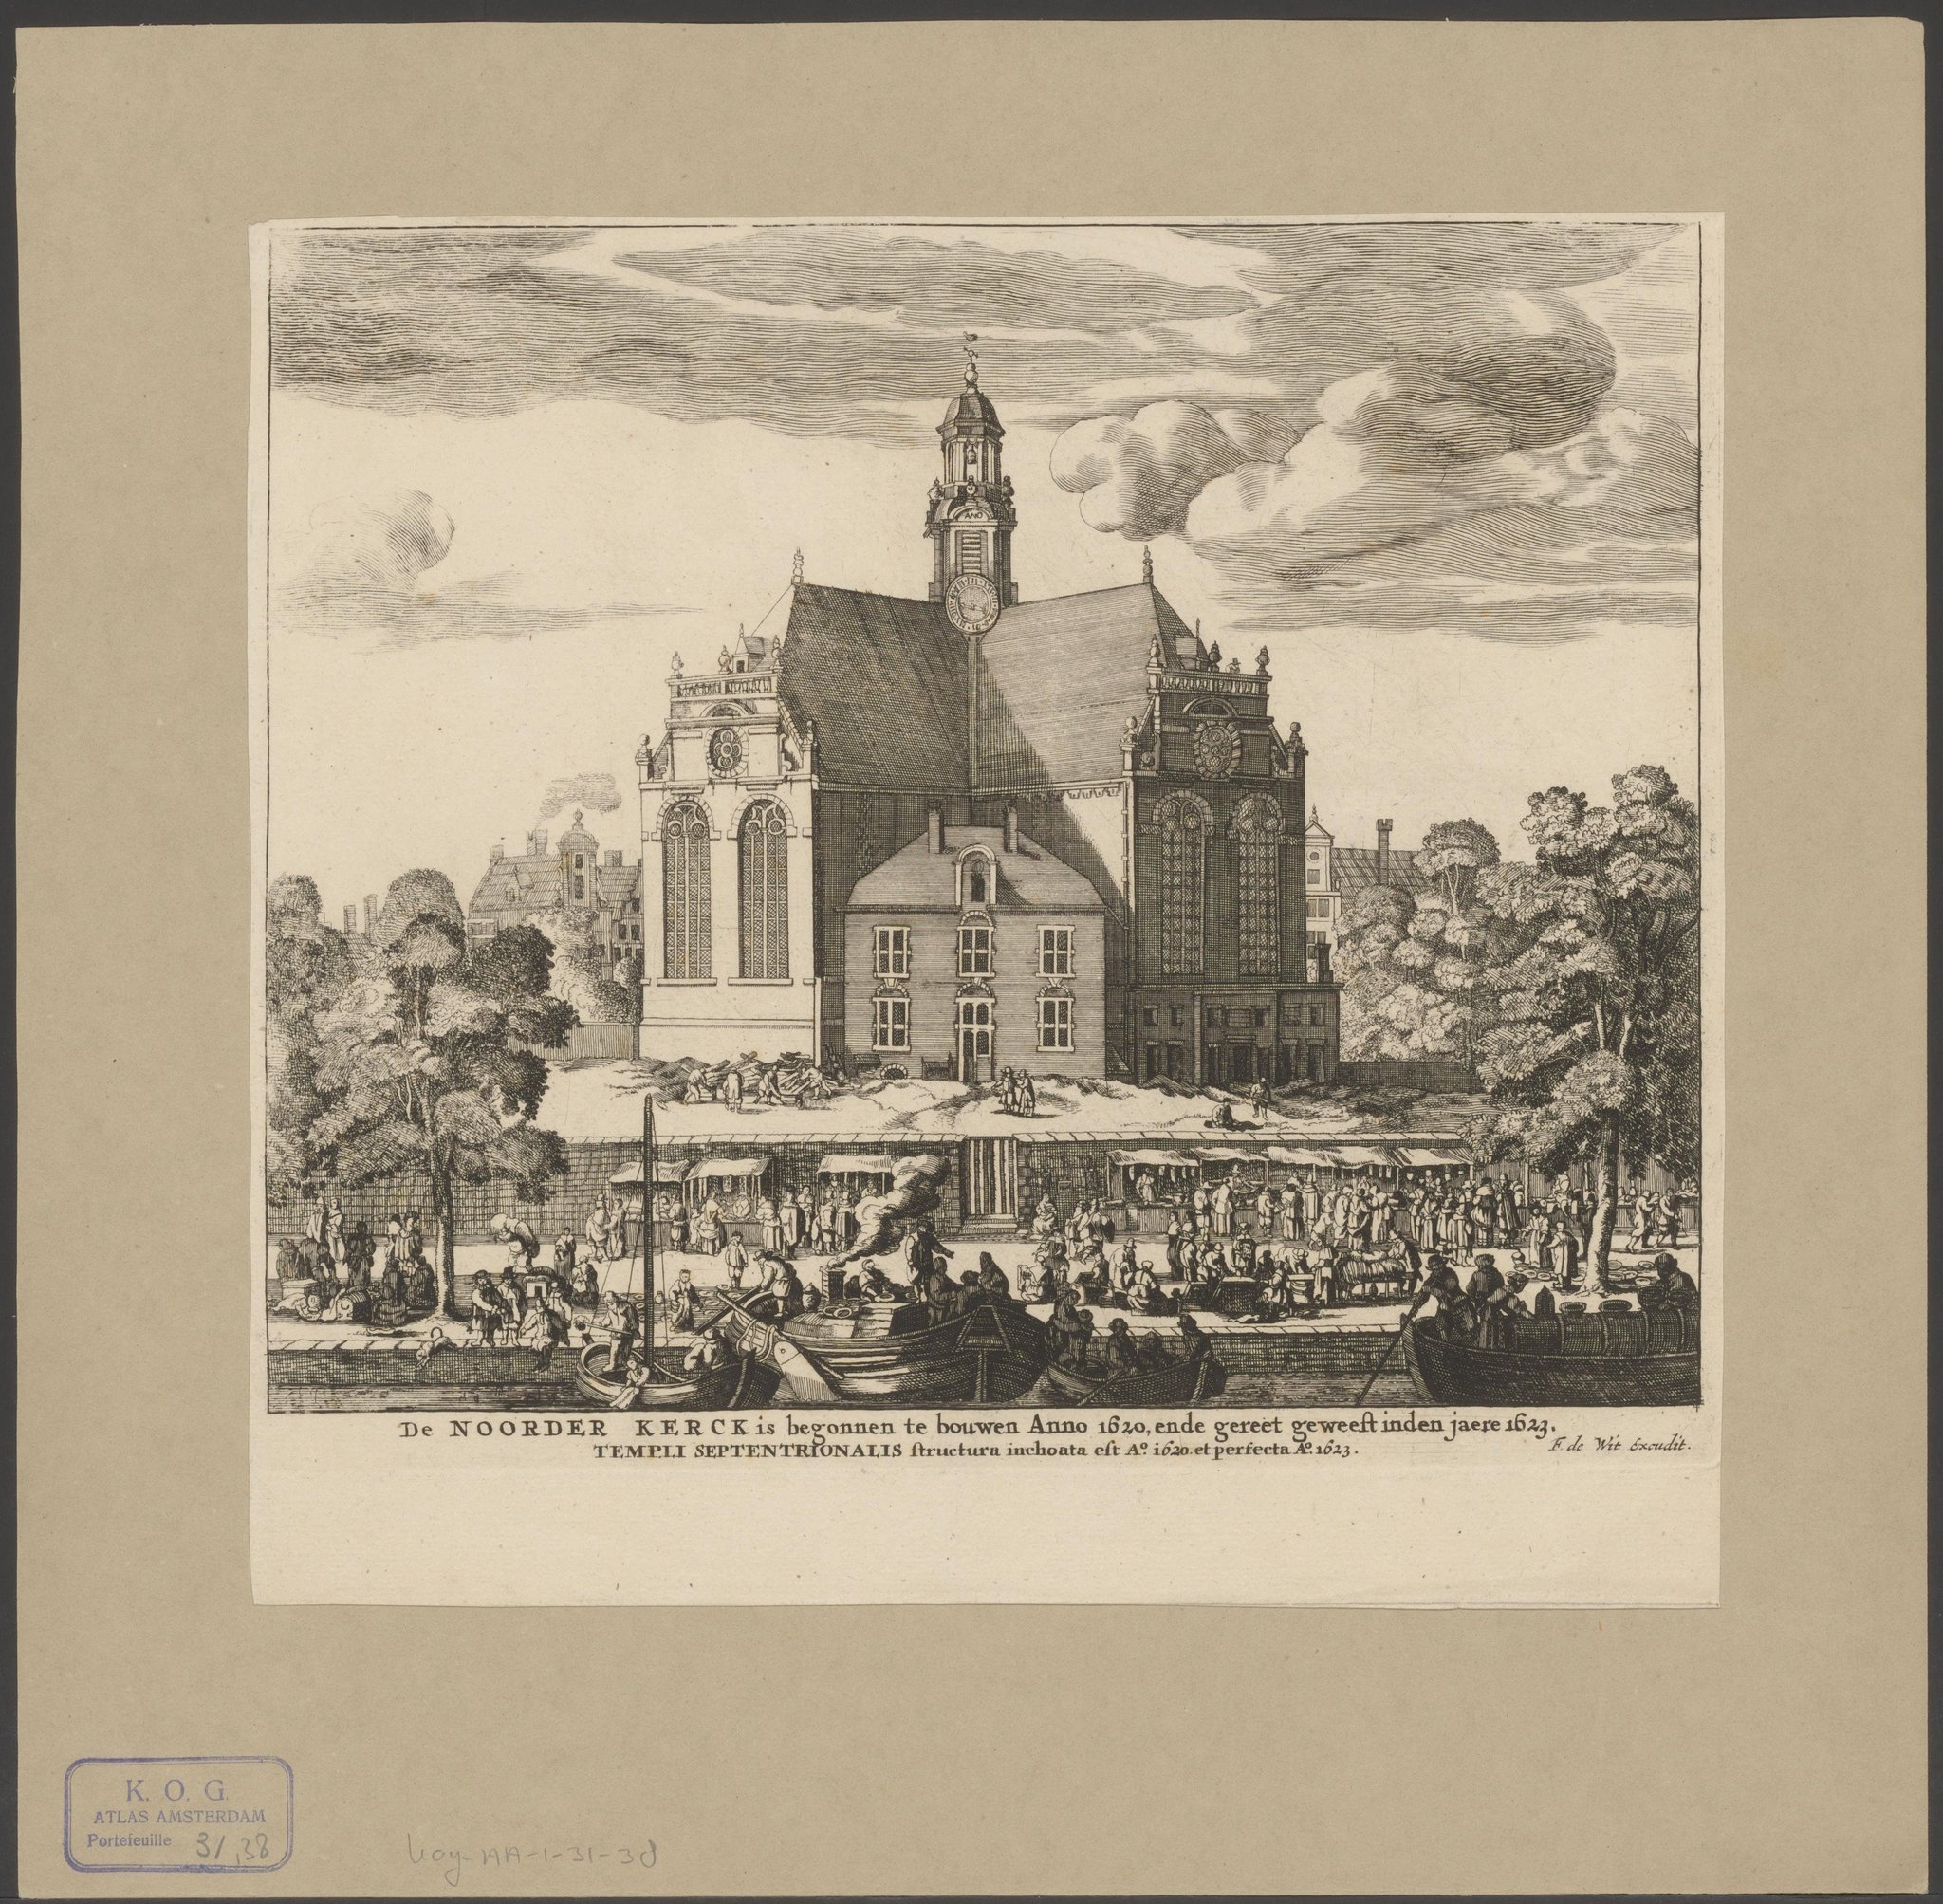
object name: print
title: De Noorder Kerck is begonnen te bouwen Anno 1620, ende gereet geweest inden jaere 1623 / Templi Septentrionalis structura inchoata est Ao. 1620 et perfecta Ao. 1623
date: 1662-1706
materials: paper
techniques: engraving, etching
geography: amsterdam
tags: stall, booth (~ market), ships (in general), church (exterior), market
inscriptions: collector's mark: Lugt 1641b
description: Rechtsonder genummerd: 4. Onderwerpsrubriek binnen de Atlas Amsterdam: Kerkwezen: Hervormde Gemeente: Noorderkerk.